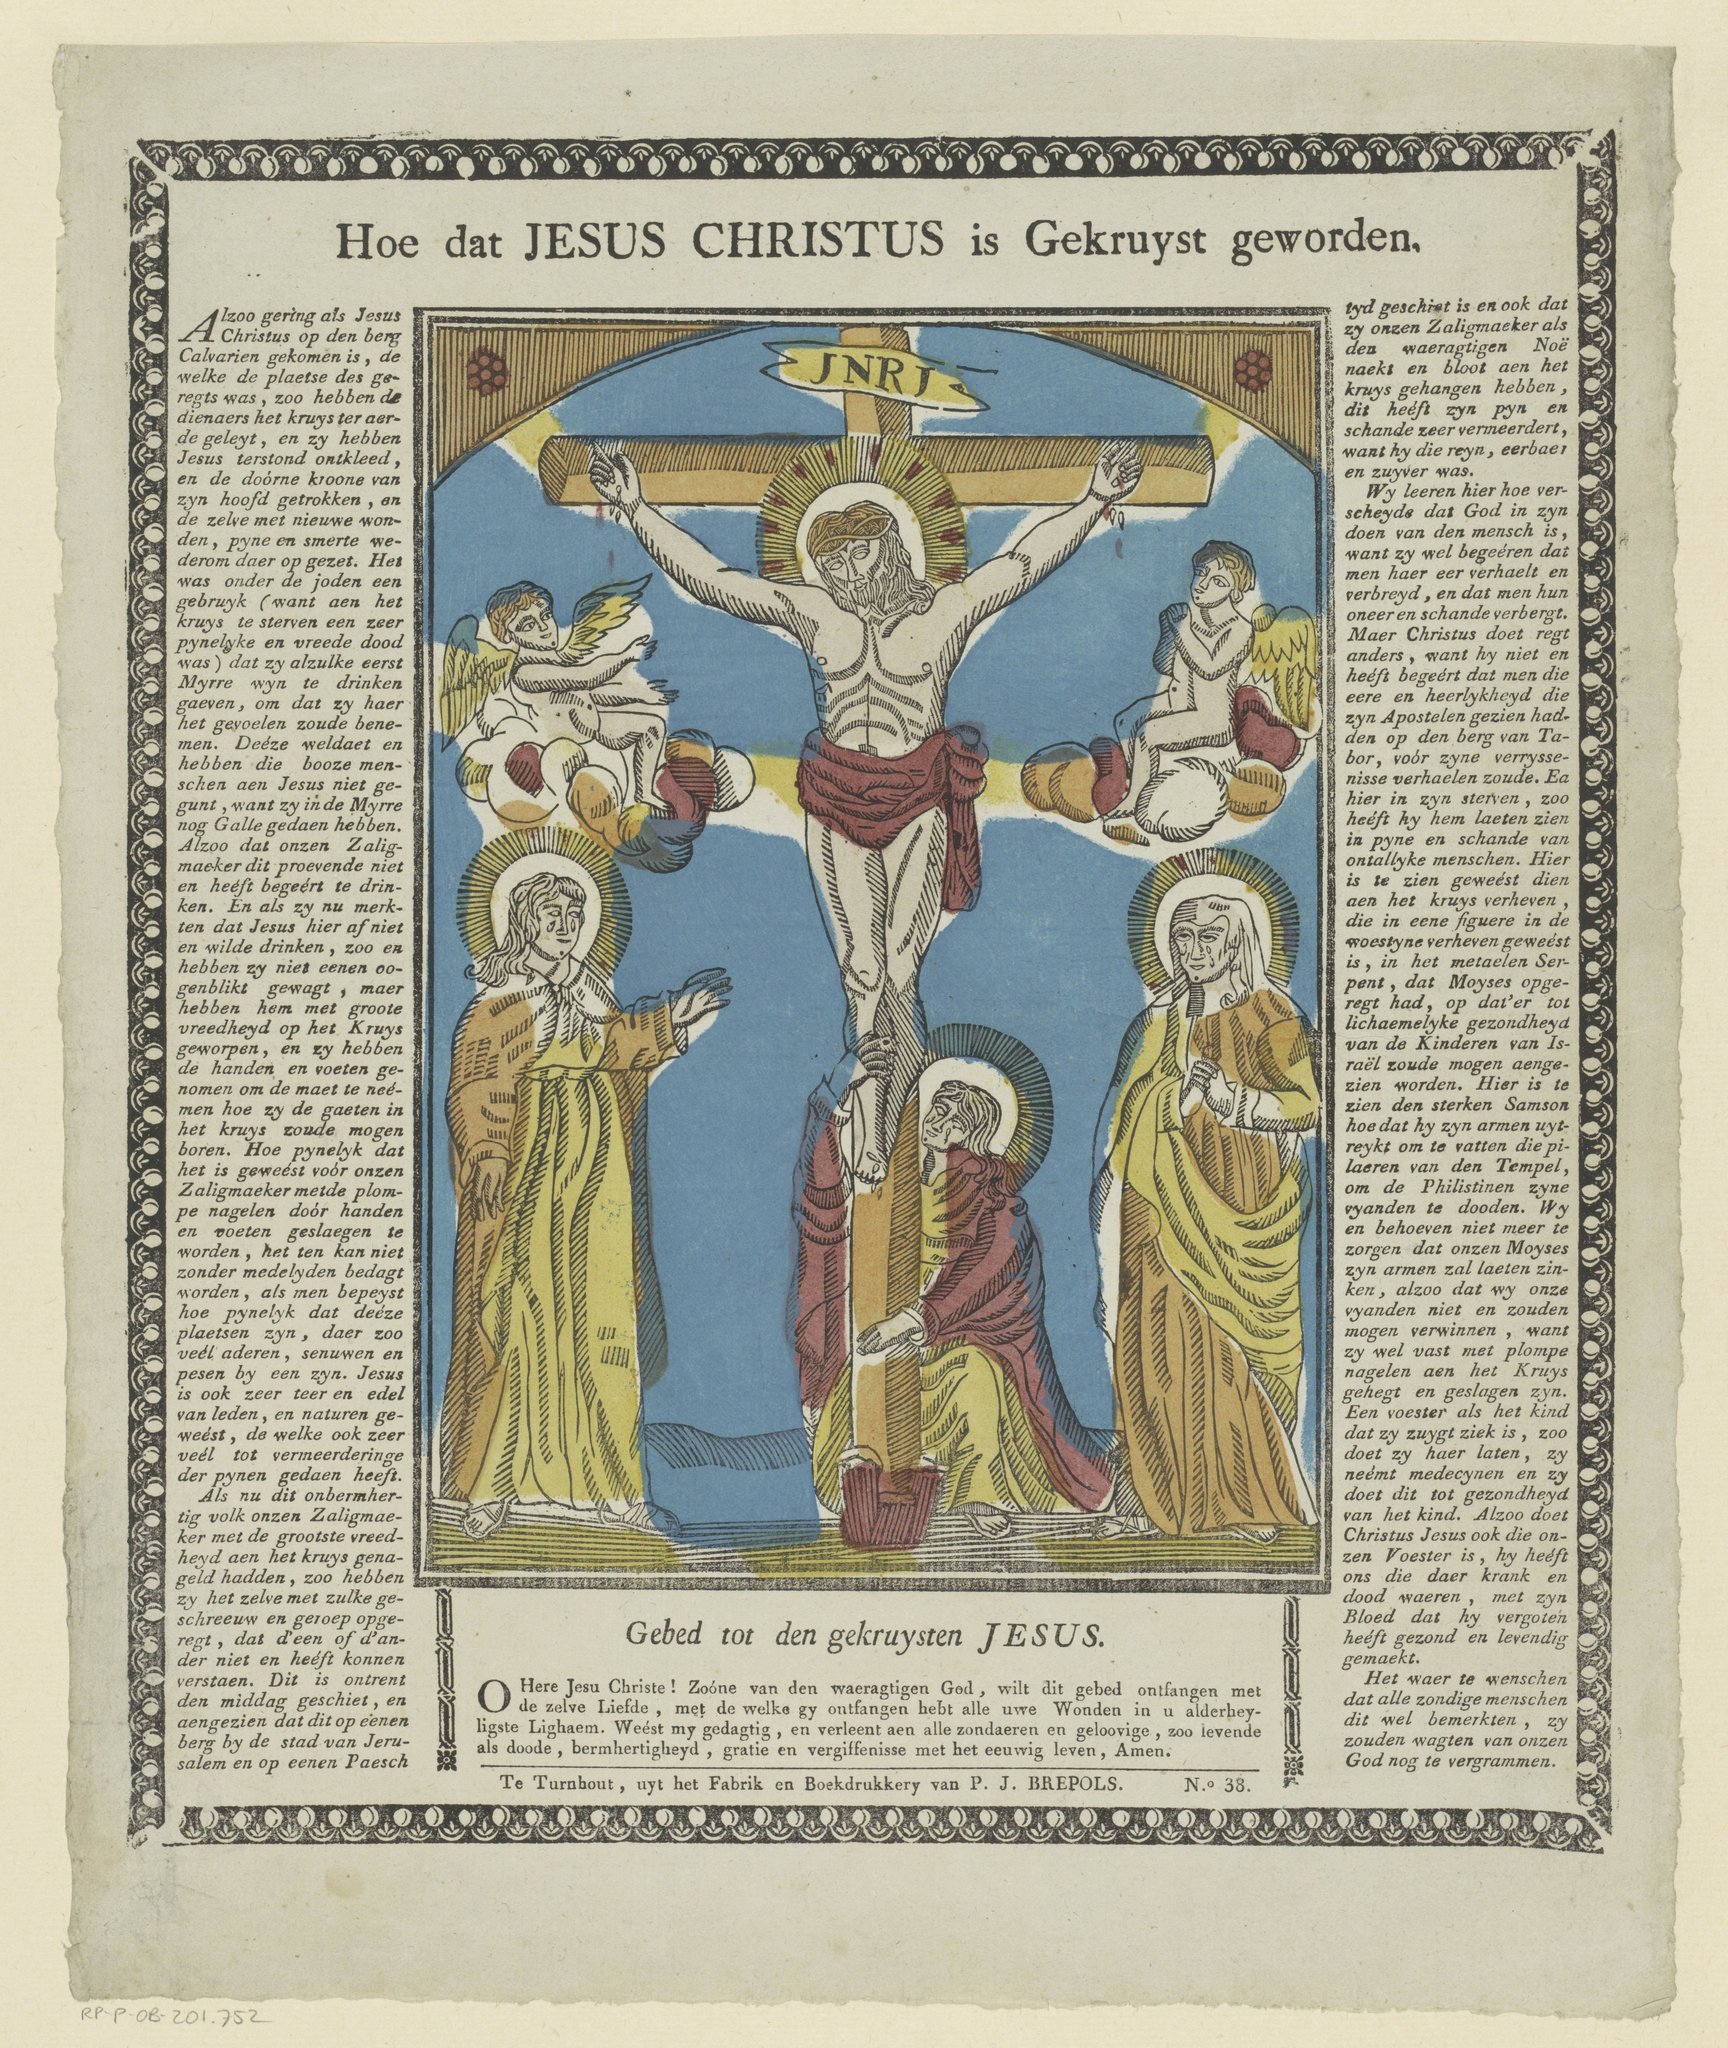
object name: print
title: Hoe dat Jesus Christus is gekruyst geworden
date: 1800-1833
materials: paper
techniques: colour, letterpress printing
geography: turnhout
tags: crucified christ with mary, john, and mary magdalene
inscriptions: collector's mark: Lugt 2760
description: De Kruisiging van Christus. Maria, Johannes en Maria Magdalena onder het kruis. Rondom tekst in boekdruk in het Nederlands. Geheel omgeven door een sierrand. Genummerd rechtsonder: No. 38.